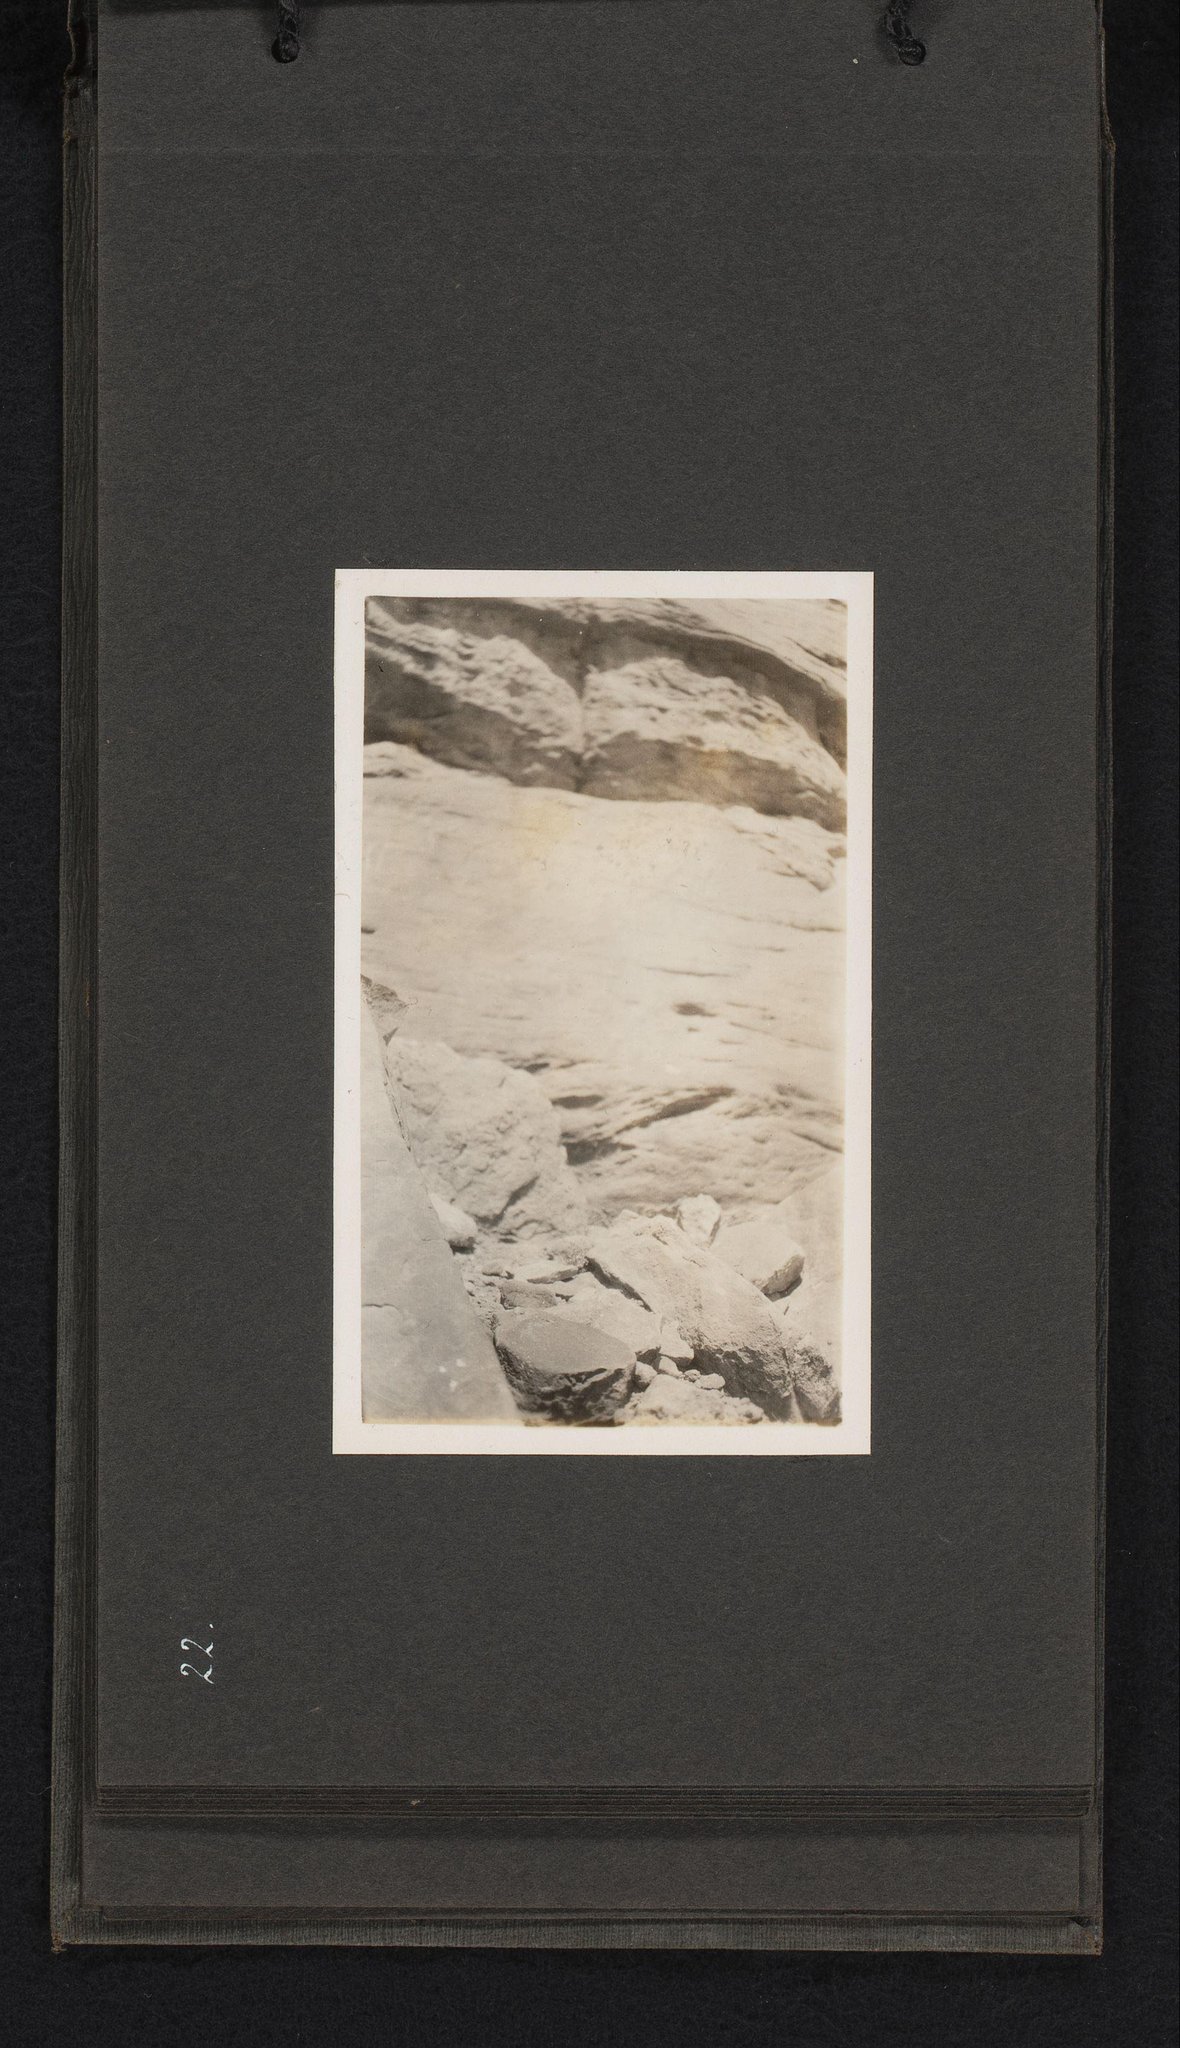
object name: album leaf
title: Rots in een bergpas, met neolytische voorstellingen (onzichtbaar op photo)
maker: a.g.a. van eelde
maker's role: engineer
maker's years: 1862-1950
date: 1927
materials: paper, photographic support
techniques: gelatin silver print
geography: algeria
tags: rocks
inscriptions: number: ‘22.’